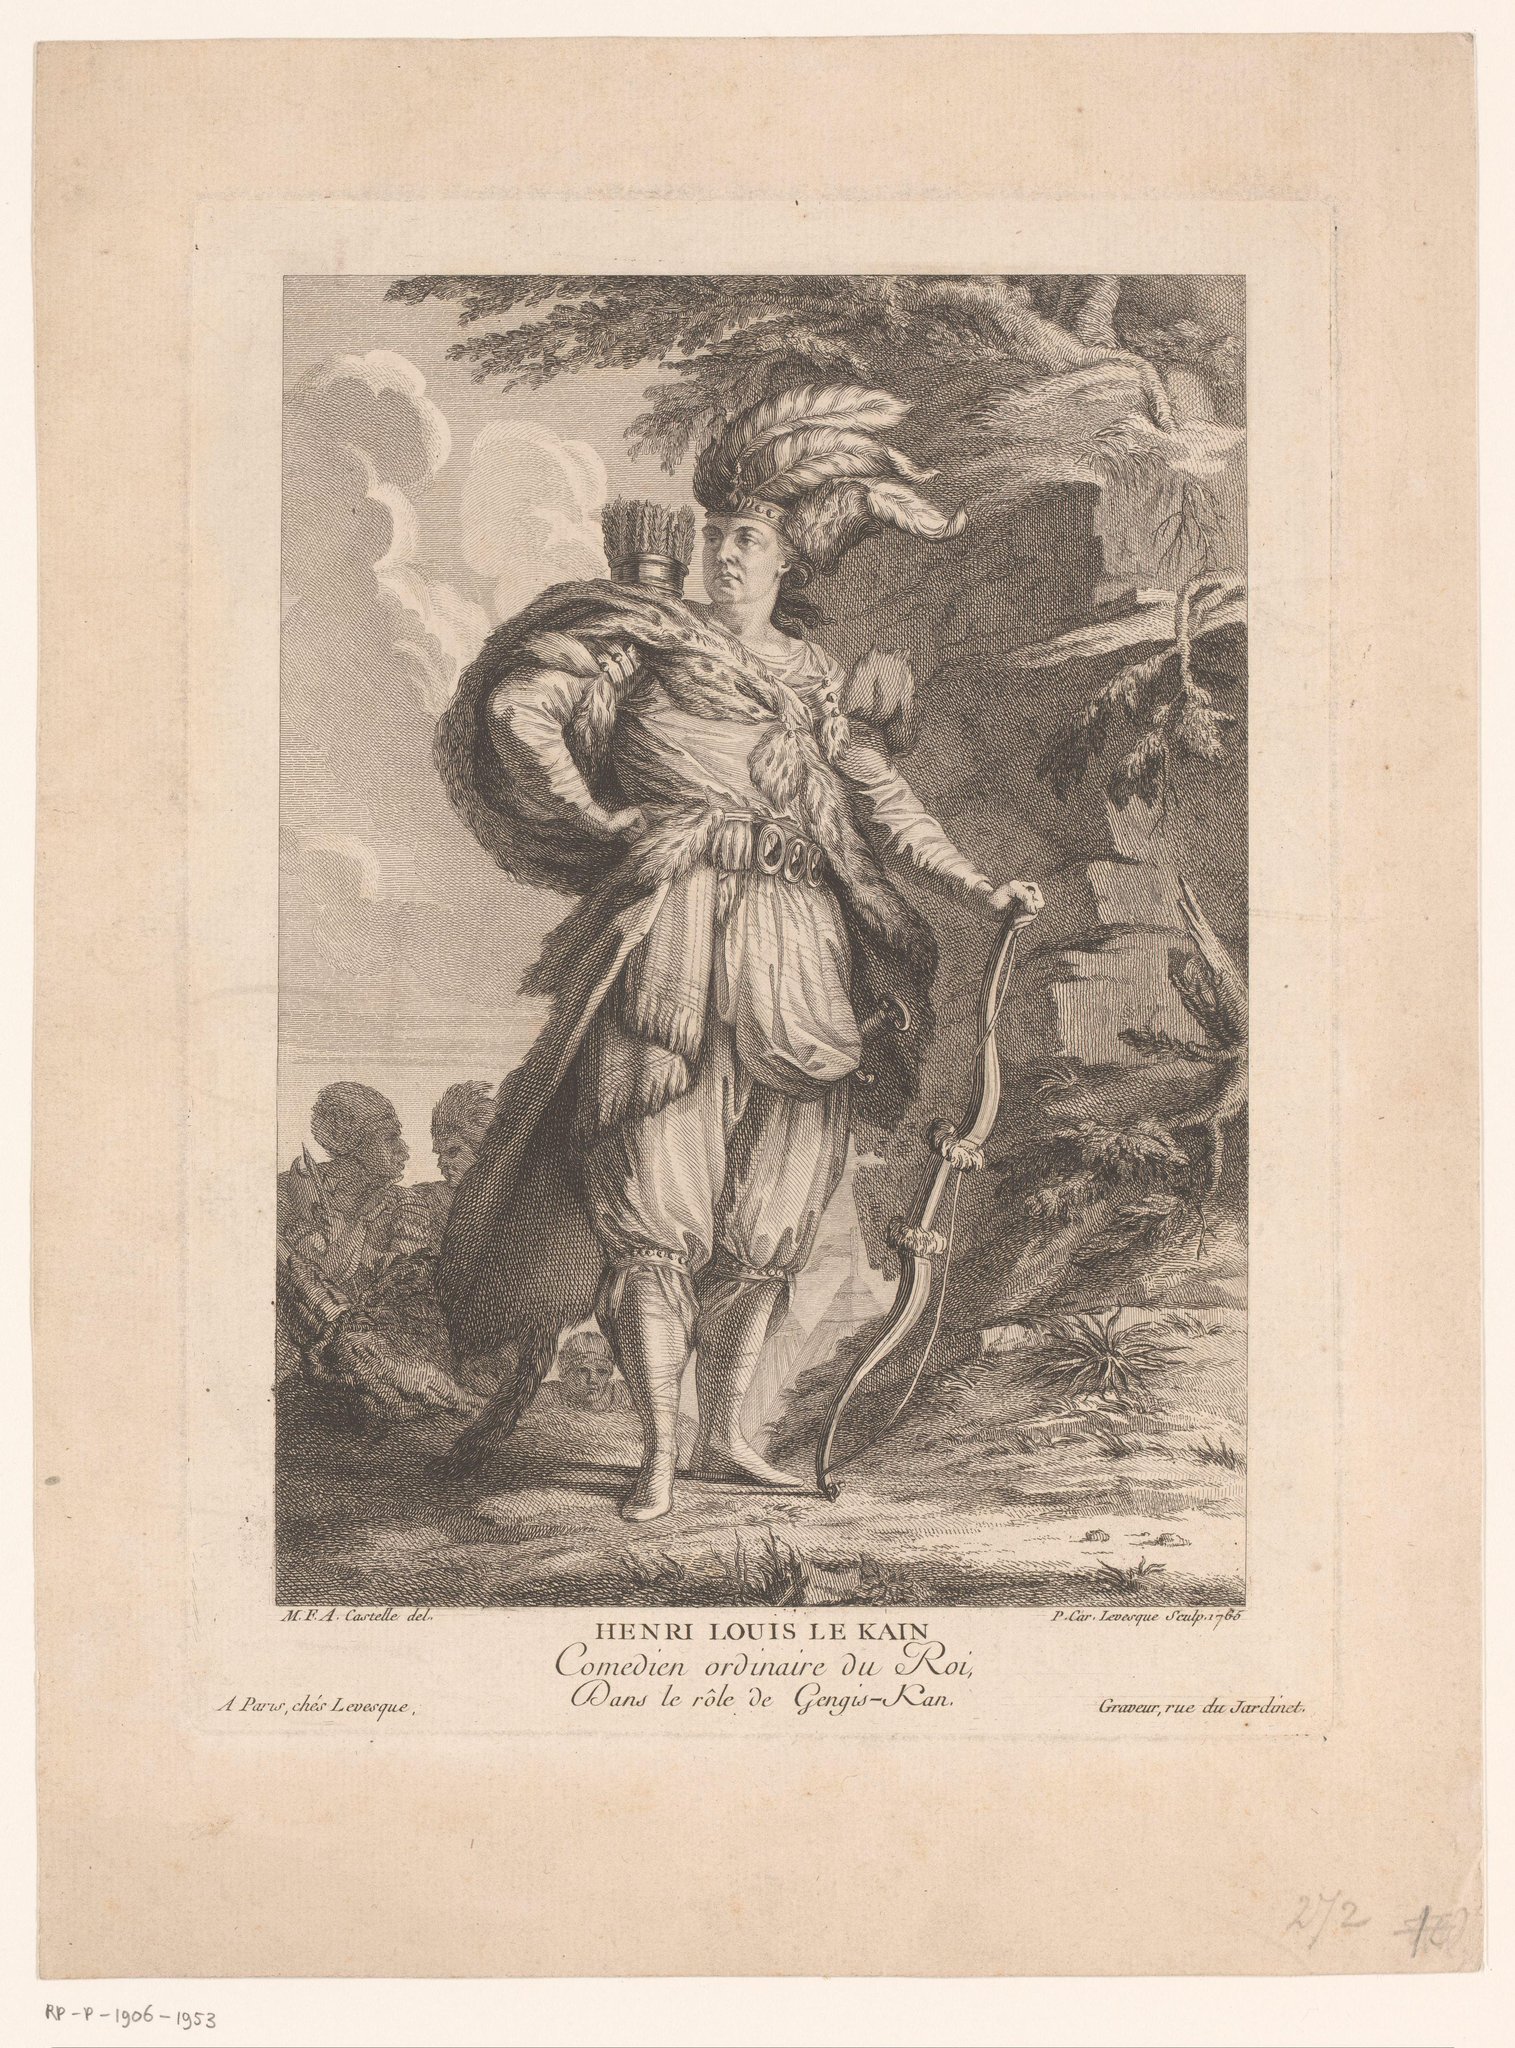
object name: print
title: Henri Louis le Kain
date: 1765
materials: paper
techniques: engraving, etching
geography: paris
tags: historical persons, portrait of actor, actress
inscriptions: collector's mark: Lugt 2228